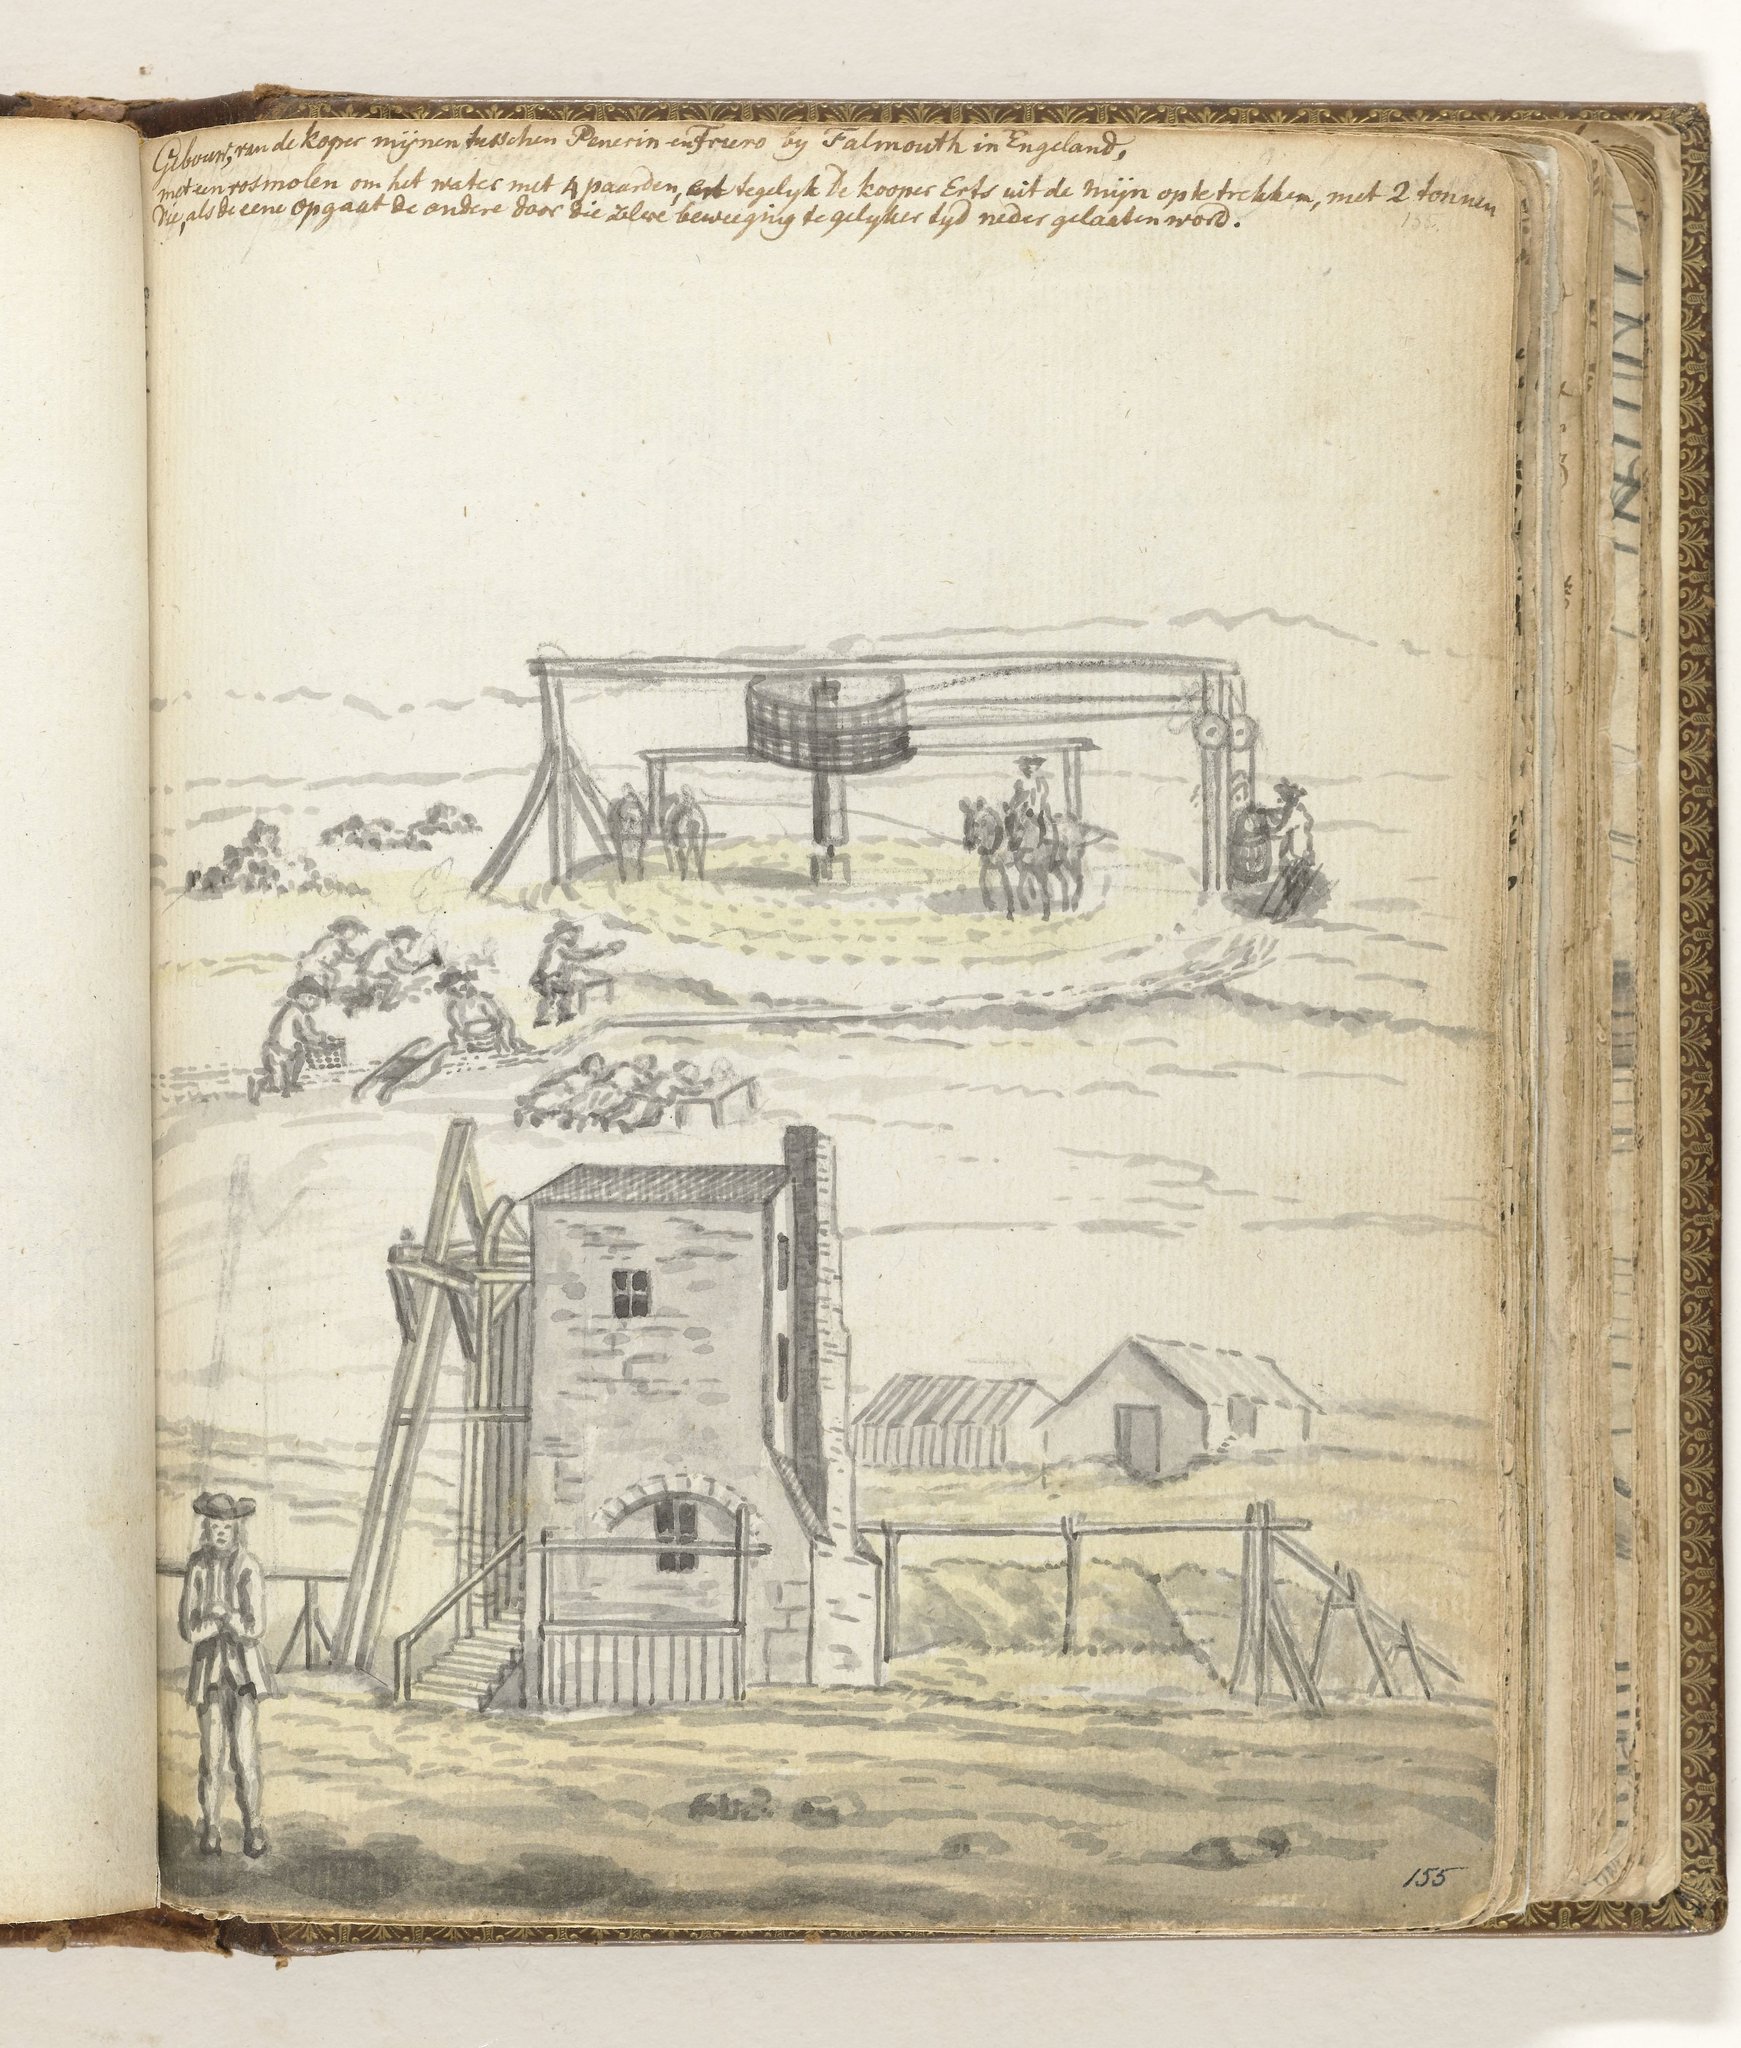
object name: drawing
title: Kopermijn en rosmolen bij Falmouth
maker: jan brandes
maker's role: draughtsman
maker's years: 1743-1808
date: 1706-1778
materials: ink, paper, pencil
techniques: brush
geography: cornwall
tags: minerals and metals: copper, treadmill, mine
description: Kleurtekening van een door vier paarden aangedreven molen die water en koper uit de mijn omhooghaalt. Daaronder het schachtgebouw. Met opschrift. Onderdeel uit het schetsboek van Jan Brandes, dl. 2 (1808), p. 155.